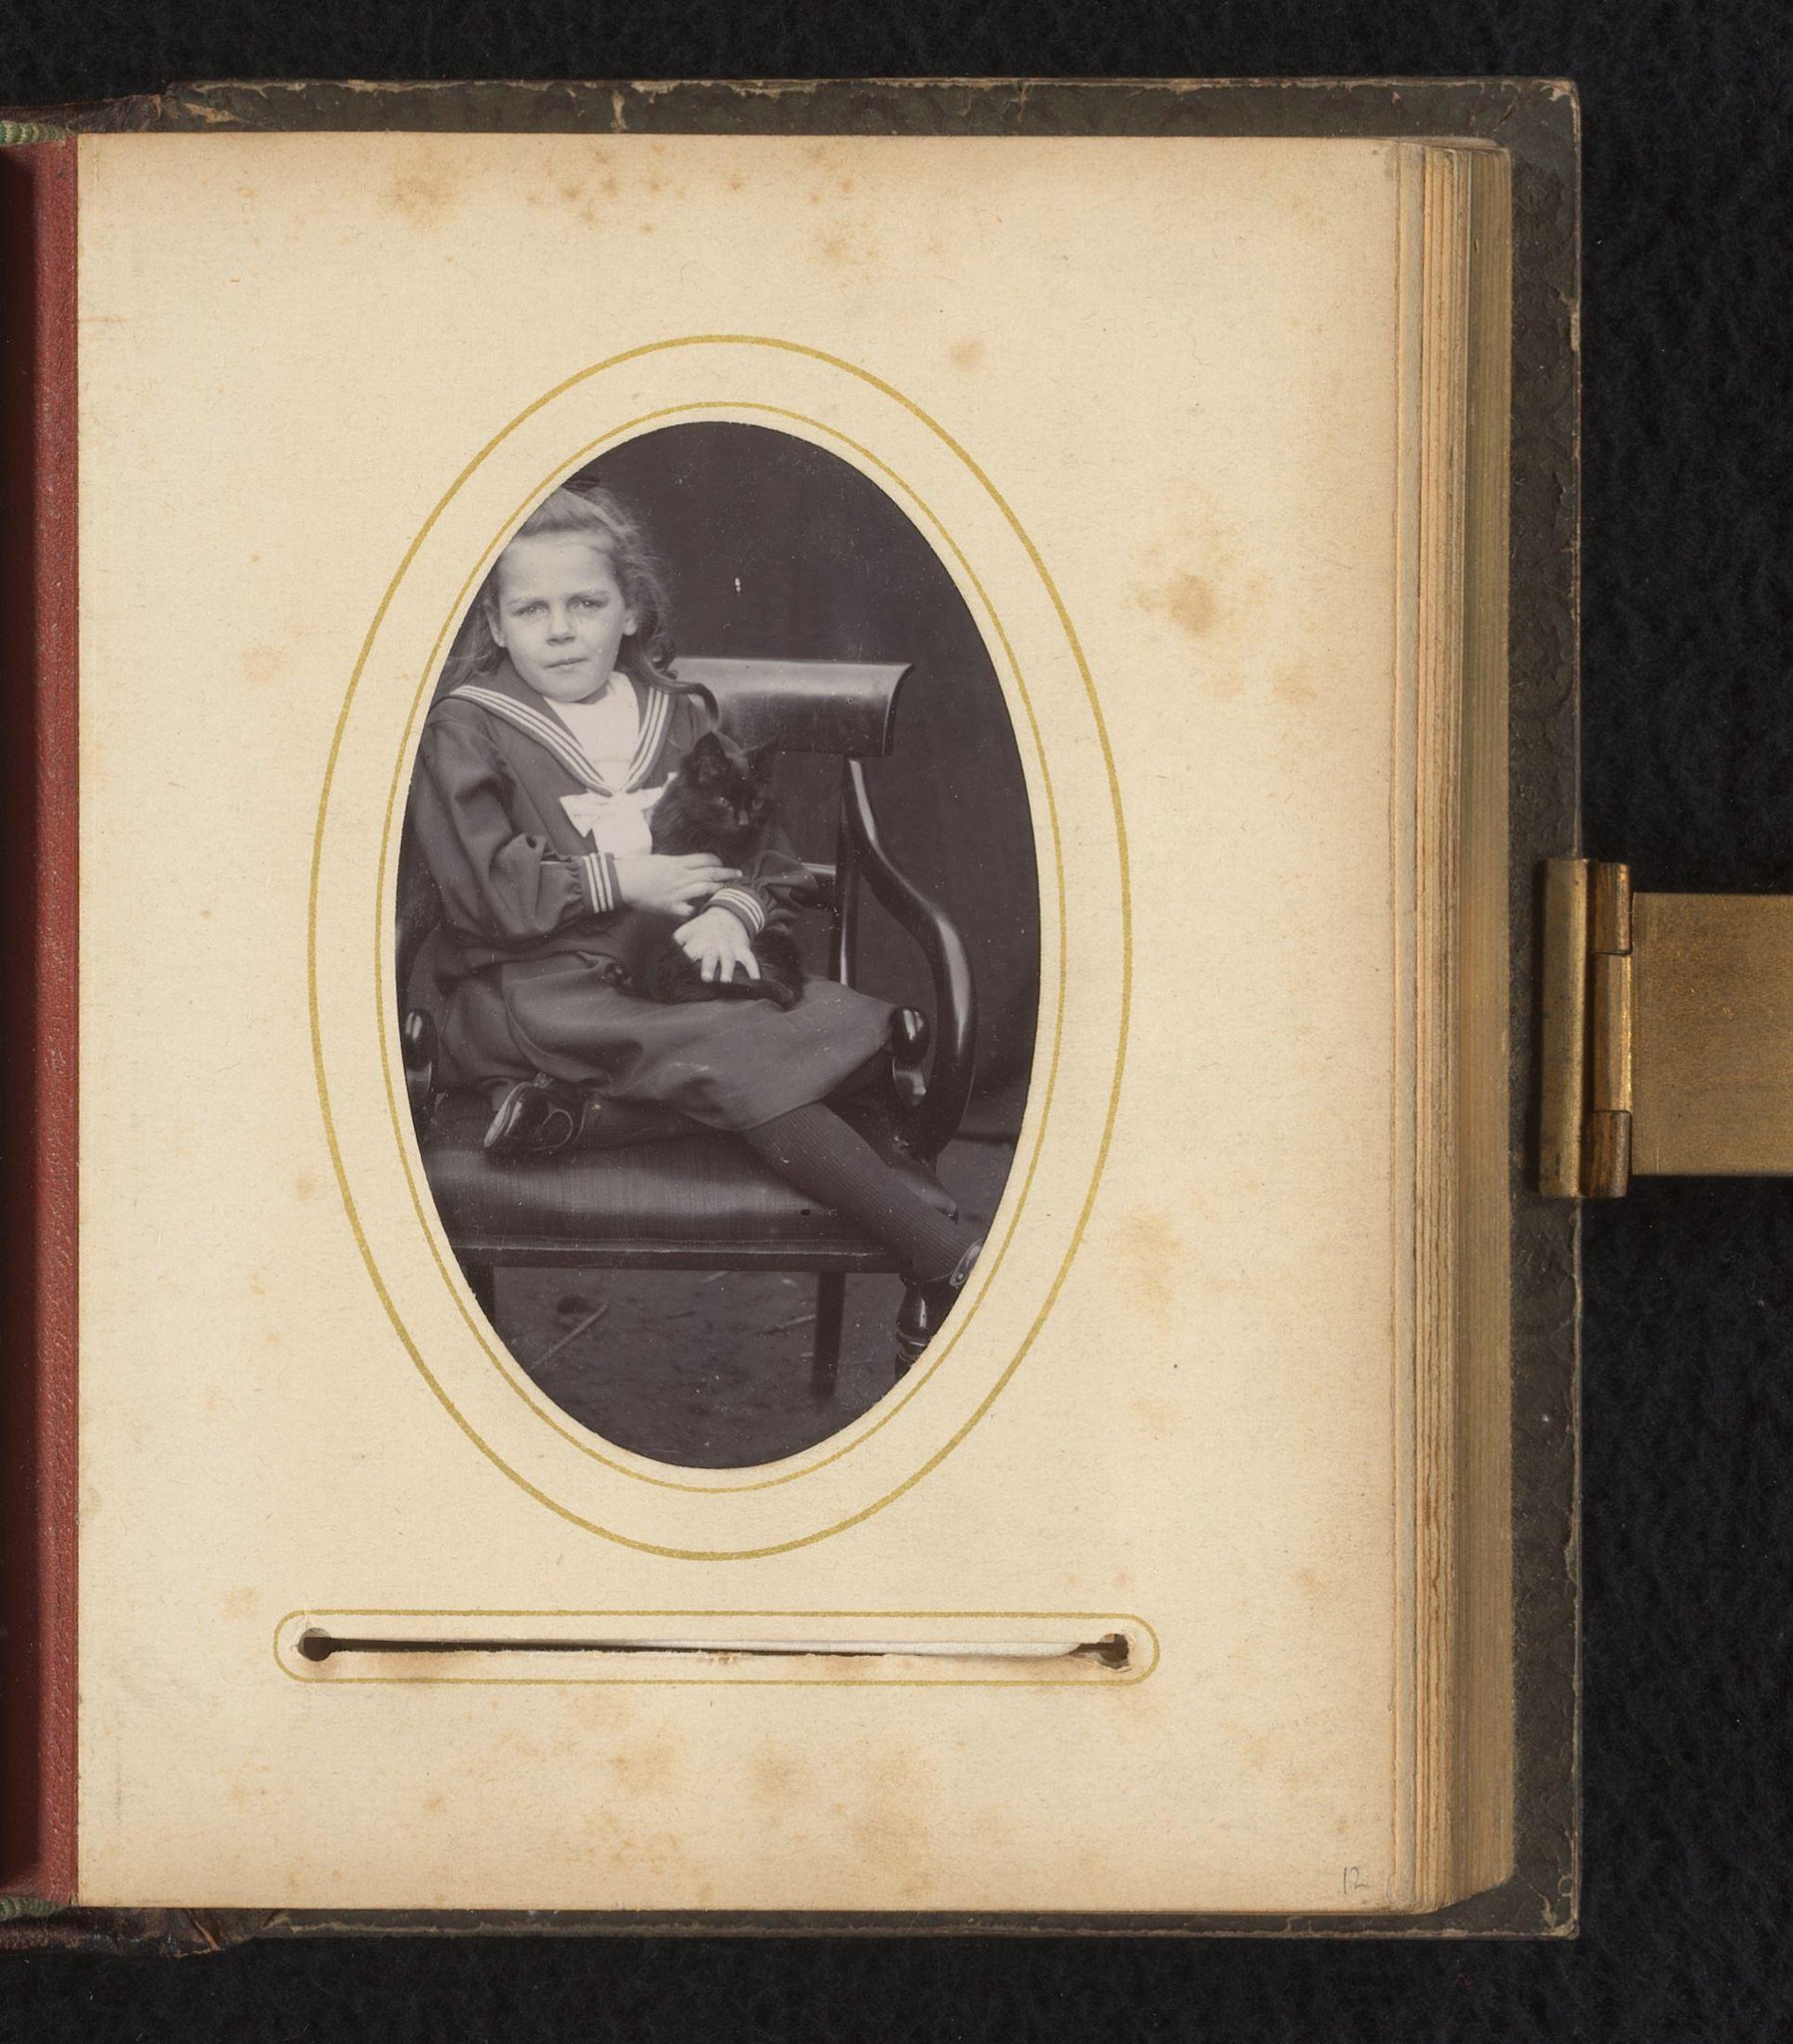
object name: album leaf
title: Portret van een meisje met een zwarte kat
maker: f. taylor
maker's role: fotograaf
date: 1880-1920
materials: cardboard, photographic support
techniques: gelatin silver print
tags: cat, historical persons, girl (child between toddler and youth)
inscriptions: name: ‘F. Taylor’